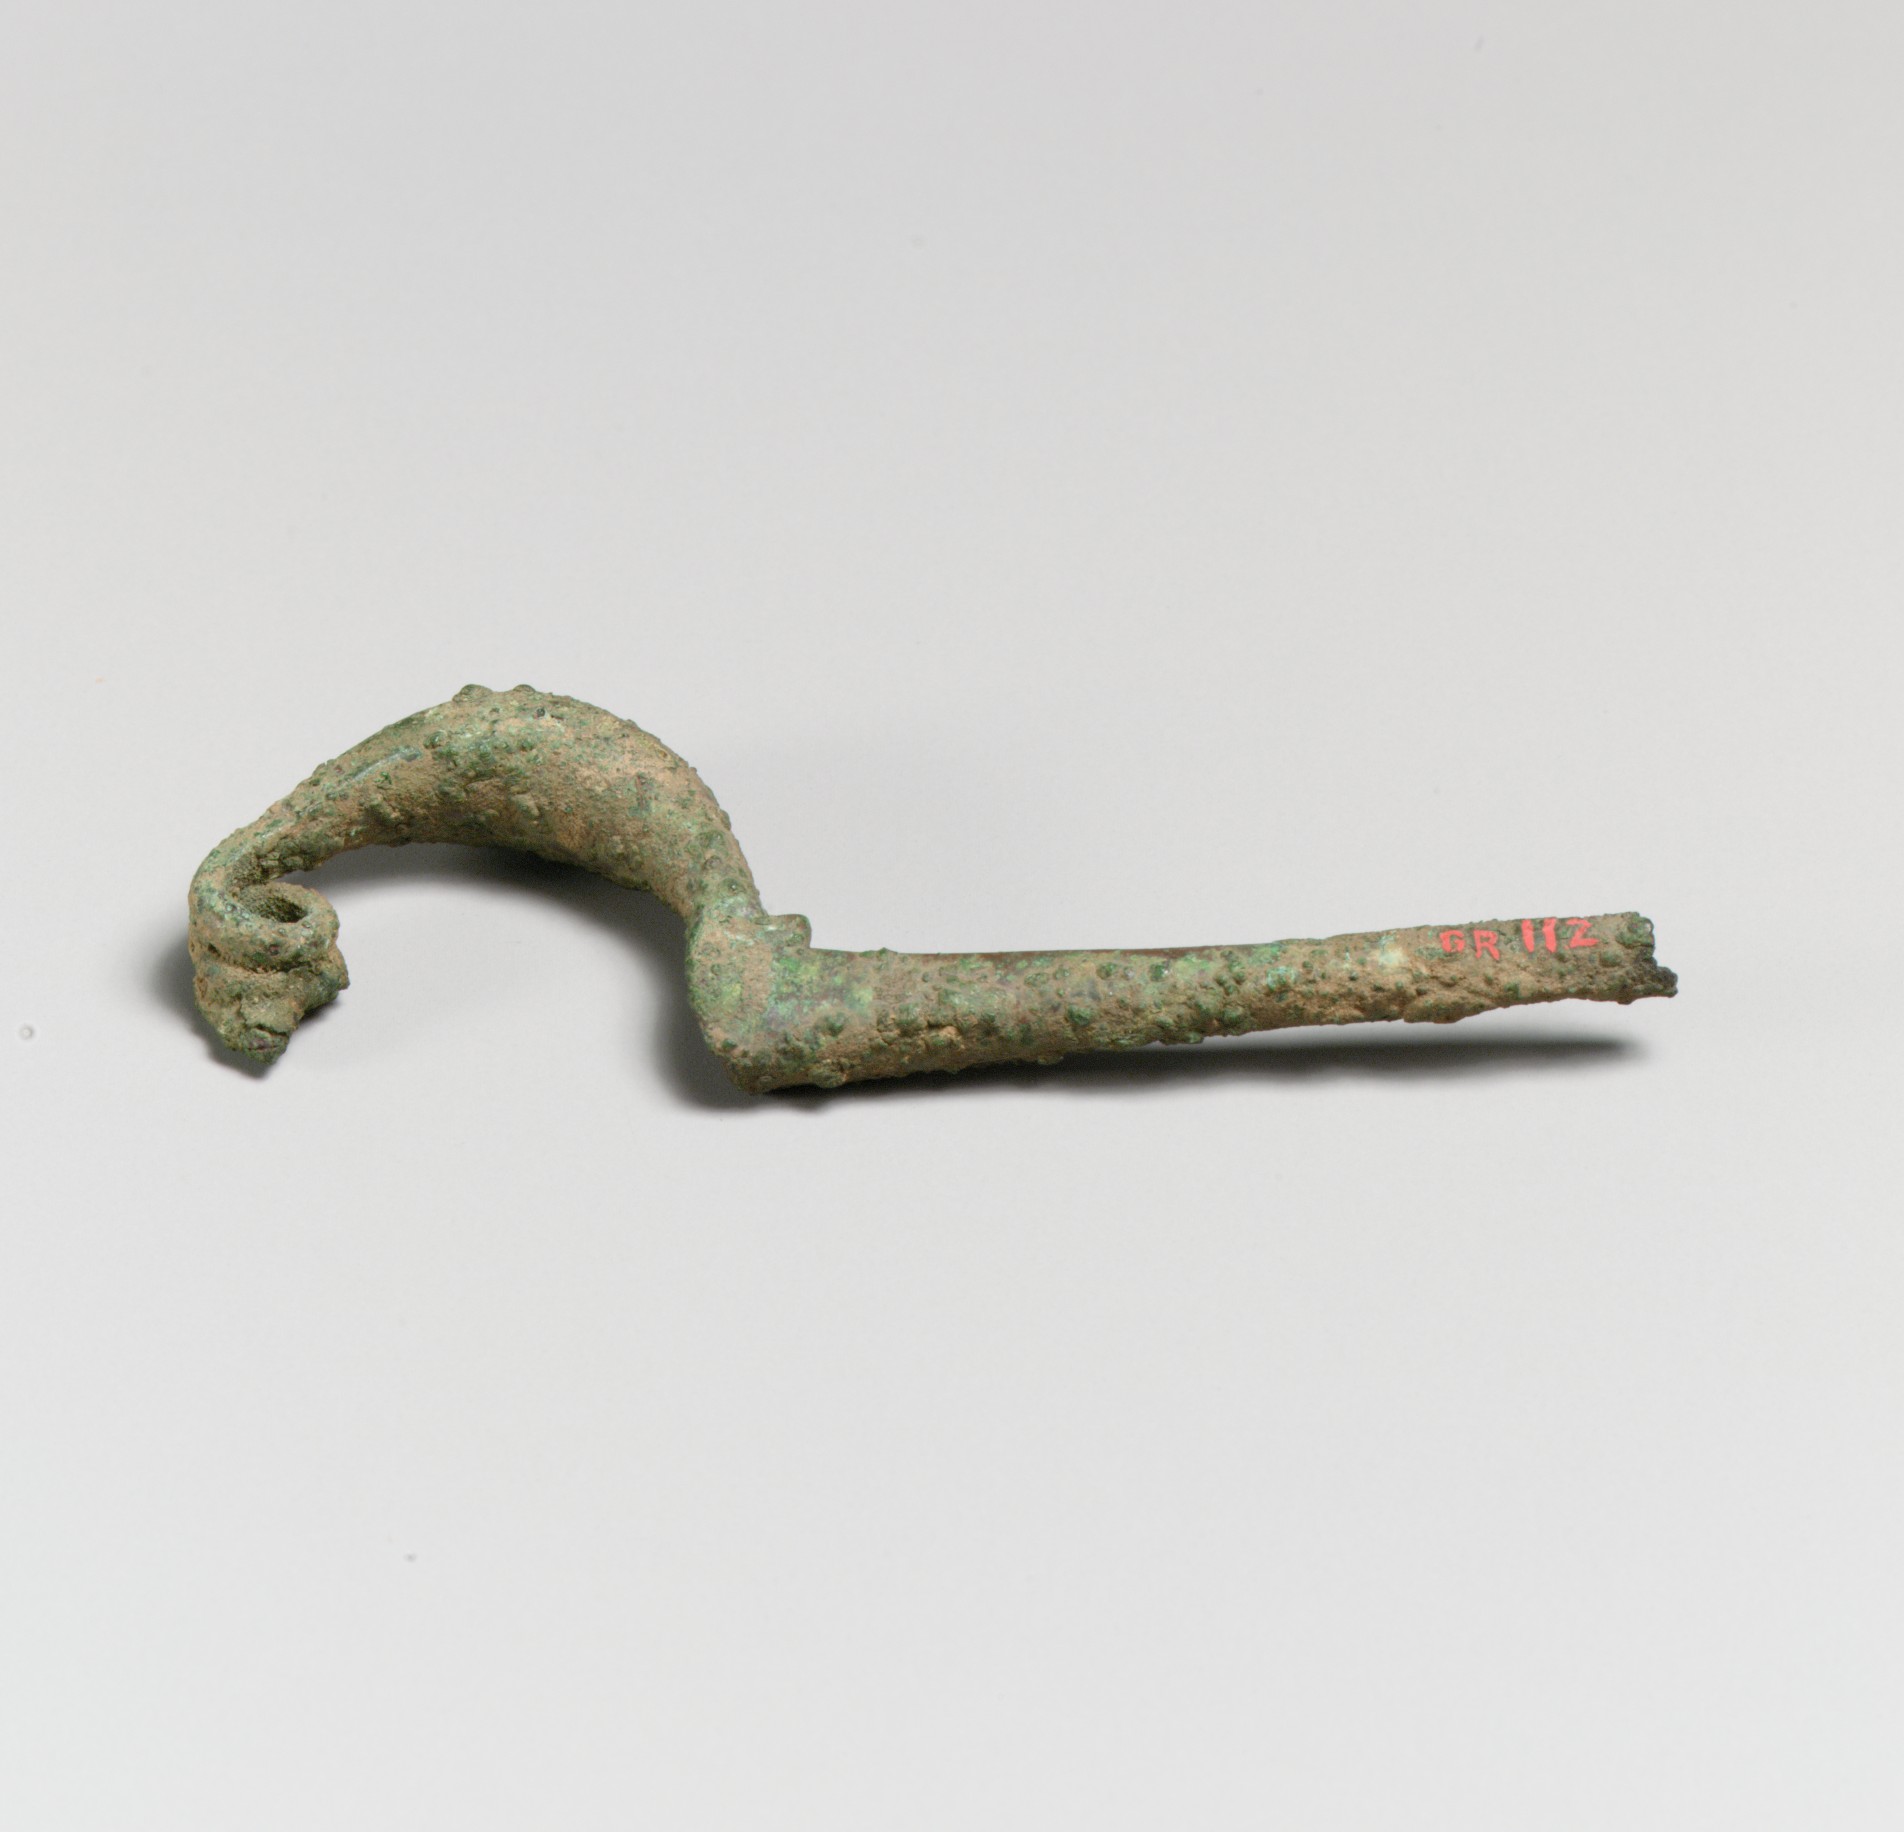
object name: fibula, boat shaped type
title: Fibula, boat-shaped type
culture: italic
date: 800-501 BCE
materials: bronze